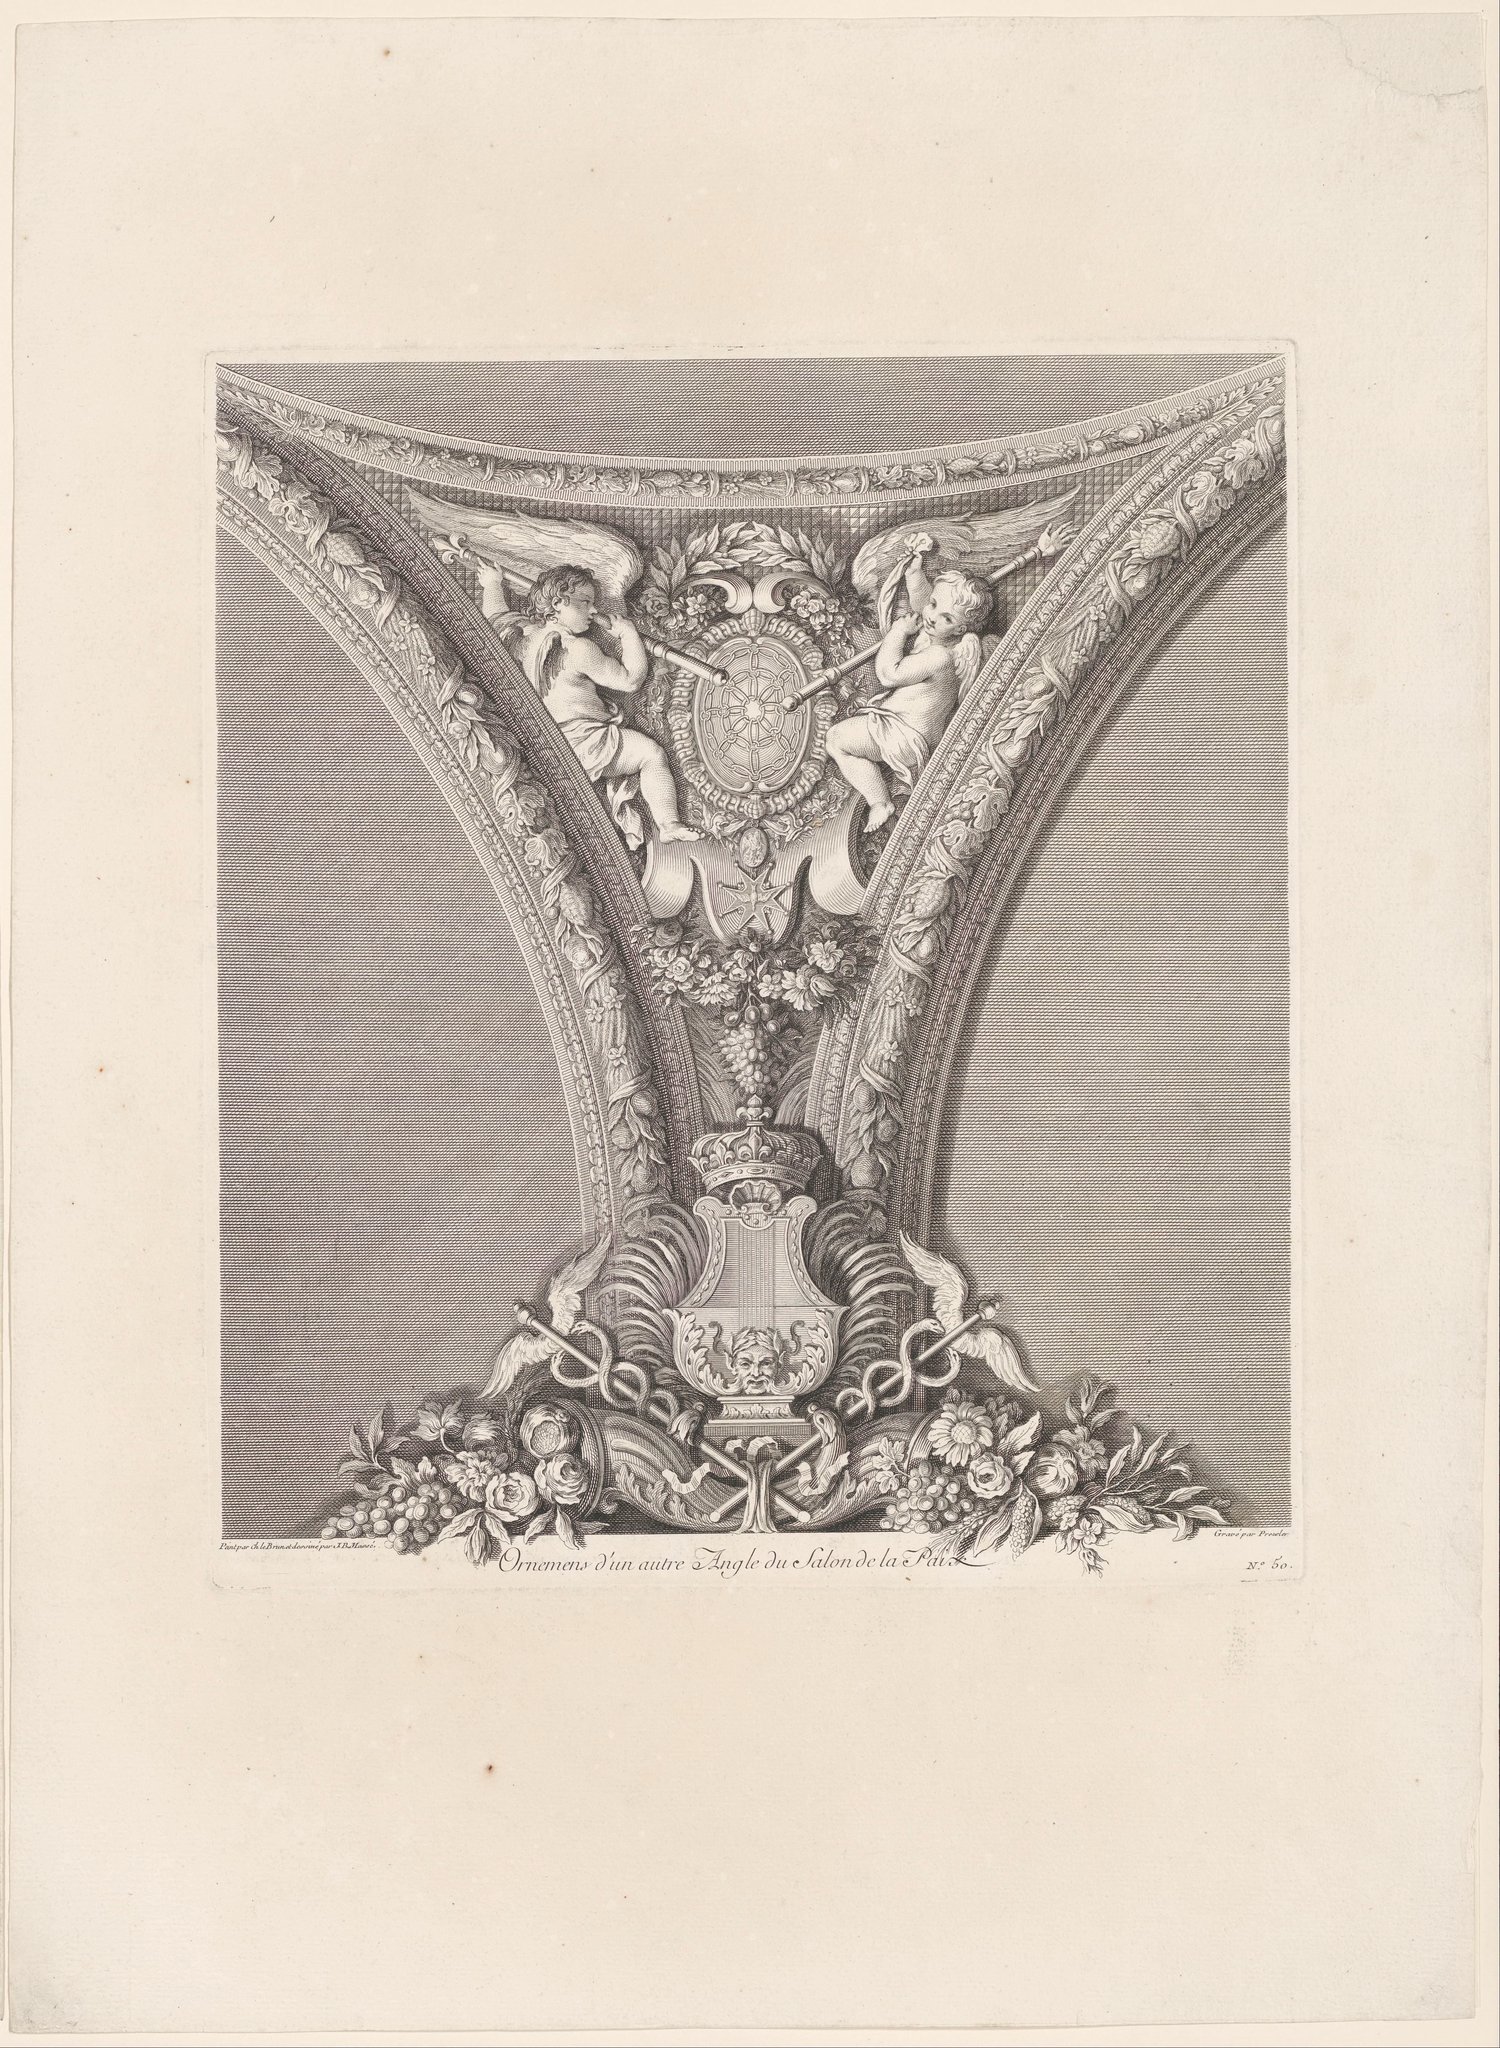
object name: print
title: Hoekversiering in het plafond van de Grote Galerij van Versailles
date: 1752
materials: paper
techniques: engraving, etching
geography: paris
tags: (decorated) ceiling, caduceus (staff with two snakes, attribute of mercury), cupids: 'amores', 'amoretti', 'putti'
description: Prent uit: Massé, Jean Baptiste. La Grande Galerie de Versailles, et les deux salons qui l'accompagnent, peints par Charles le Brun premier peintre de Louis XIV, dessinés par Jean- Baptiste Masse peintre et conseiller de l'Academie royale de peinture & sculpture; et gravés sous ses yeux par les meilleurs maitres du tems. Parijs: Imprimerie Royale, 1752.